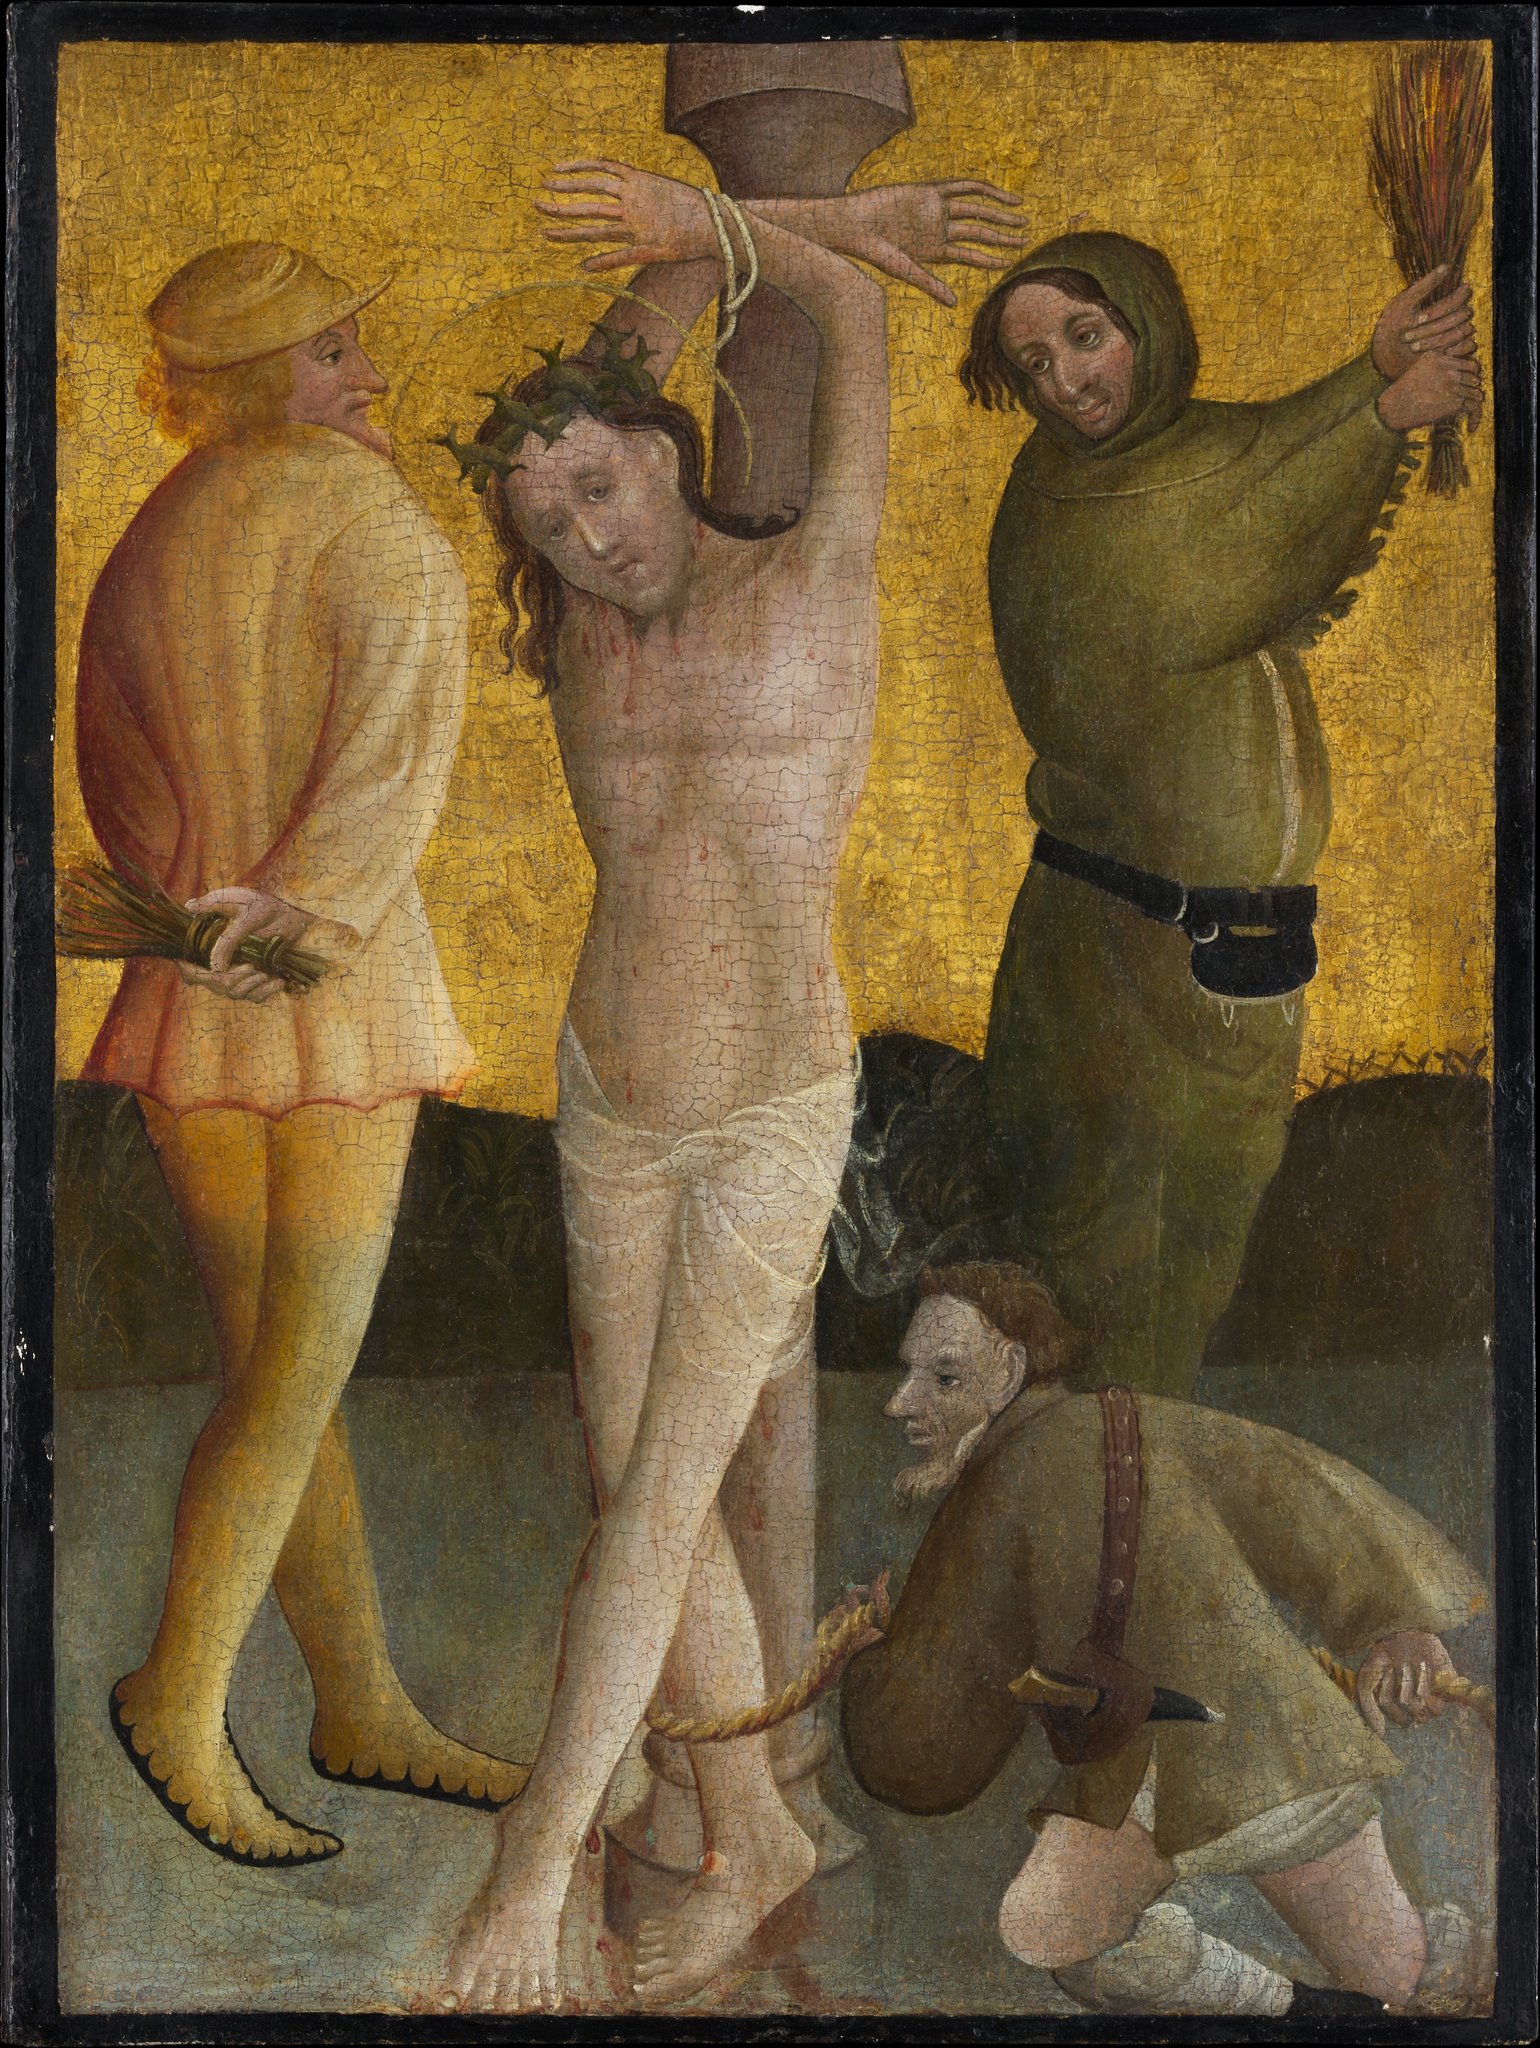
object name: painting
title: The Flagellation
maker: master of the berswordt altar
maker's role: artist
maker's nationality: german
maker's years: 1400-1435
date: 1400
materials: gold, oil, wood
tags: men,christ,flagellation